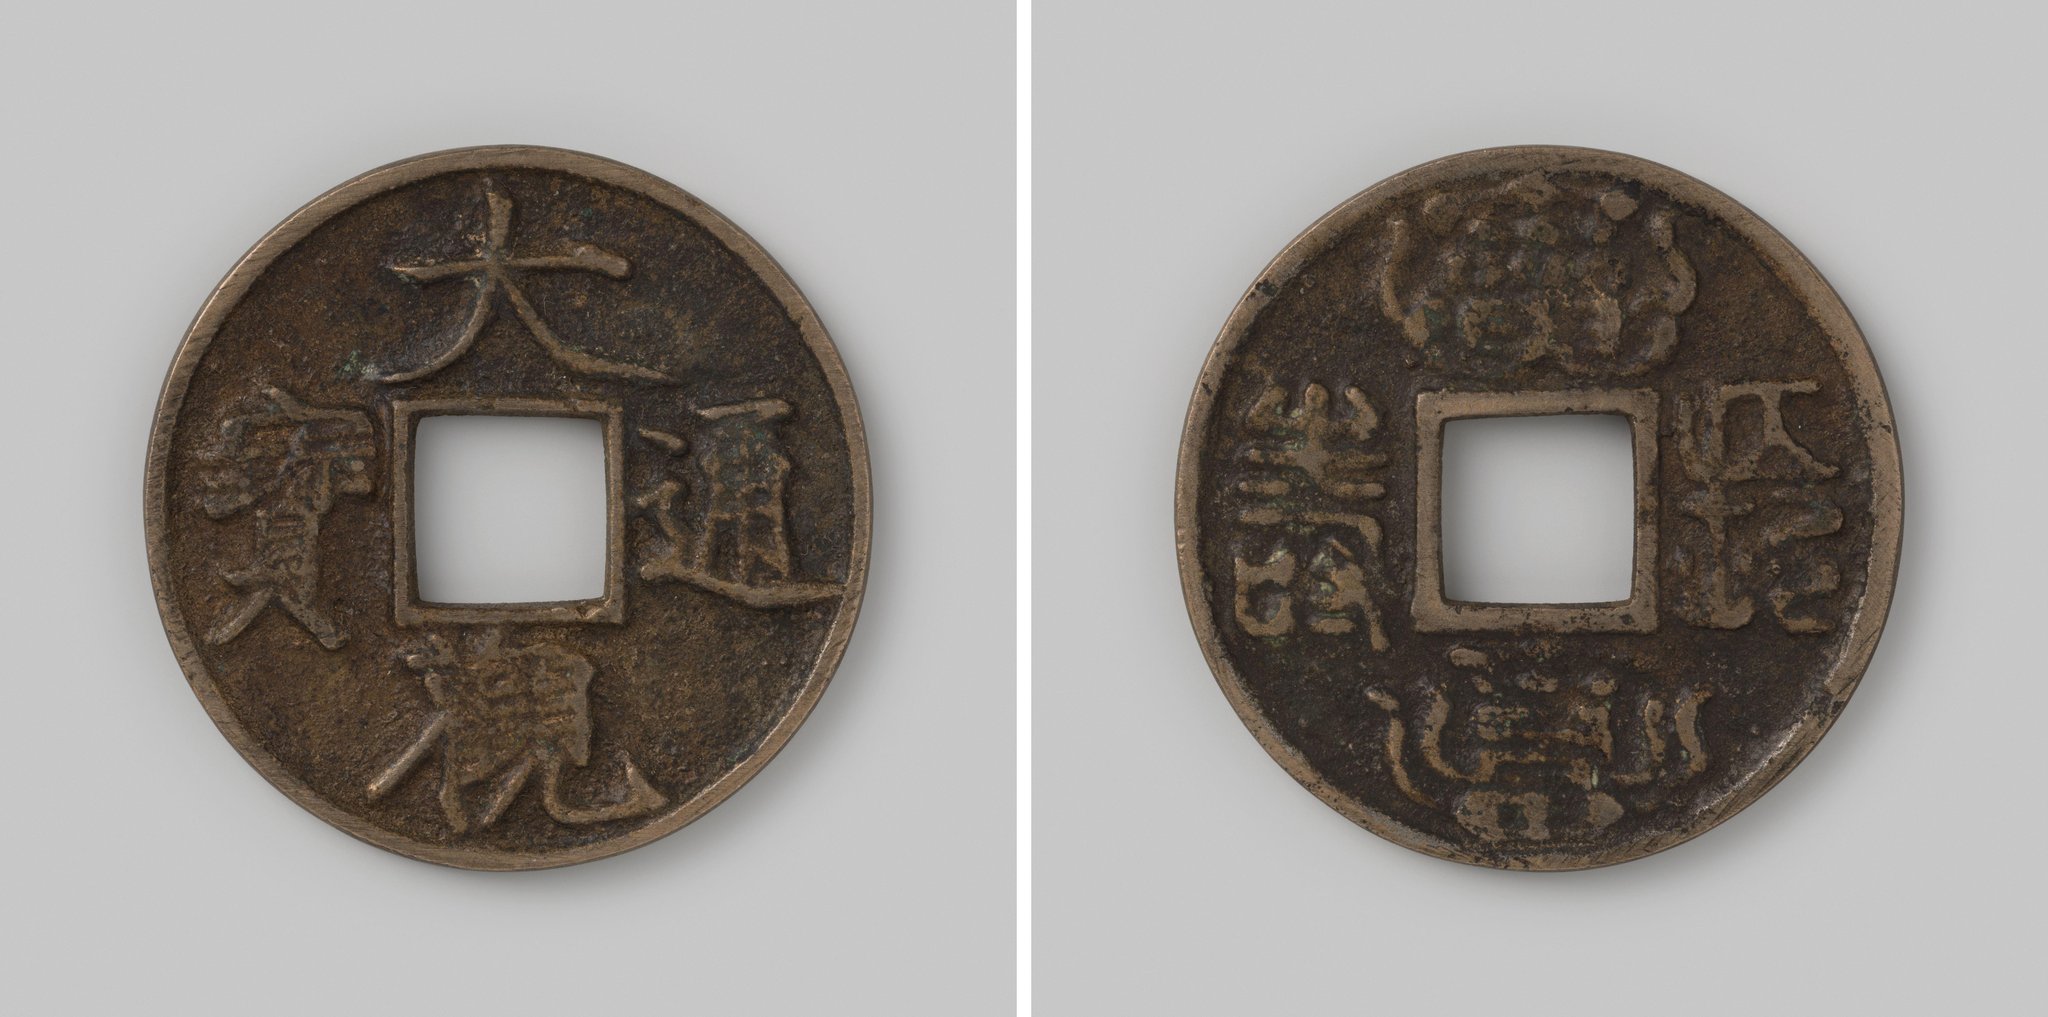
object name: coin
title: 10 cash van het keizerrijk China van keizer Hui Tsung onder de regeringsnaam Ta-kuan,1107-1110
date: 1107-1110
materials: copper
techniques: casting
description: Koperen munt. Voorzijde: binnen brede opstaande rand rondom vierkante uitsparing in het midden vier kruisgewijze geplaatste Chinese tekens, waarvan twee met de betekenis: Ta kuan. Keerzijde: glad binnen brede opstaande rand.